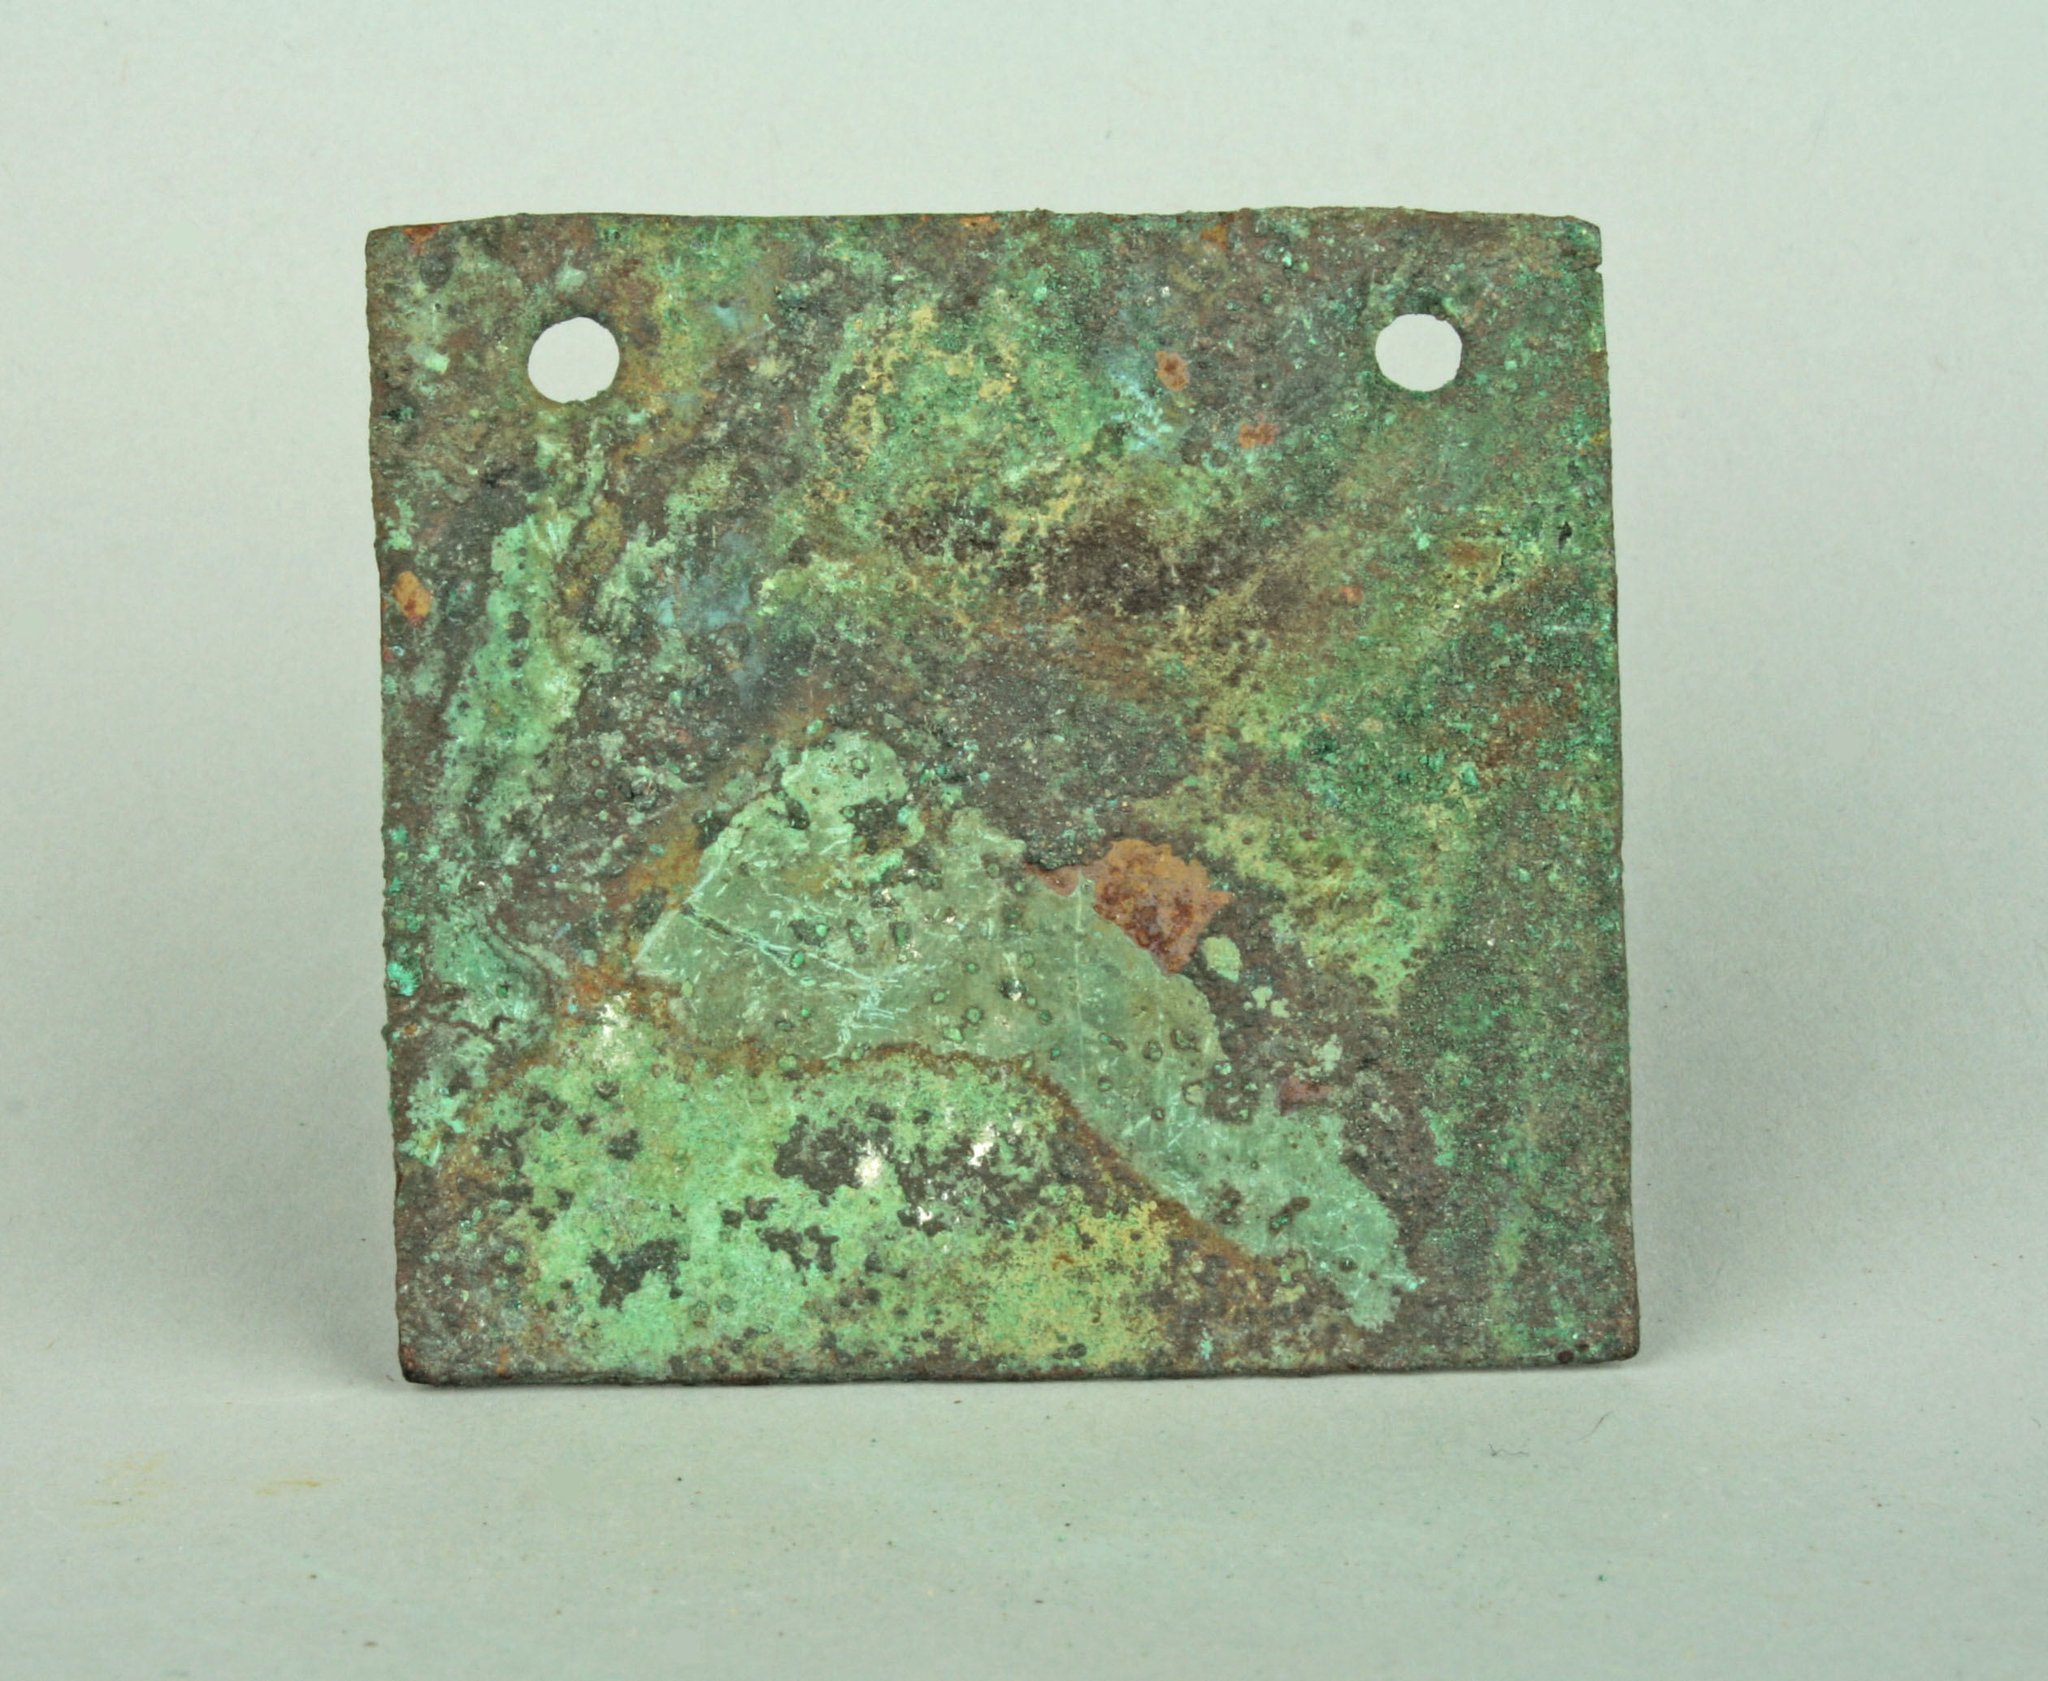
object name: plaque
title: Square Plaque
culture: vicús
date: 300 BCE-200 CE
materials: copper, gilt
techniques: hammering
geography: peru